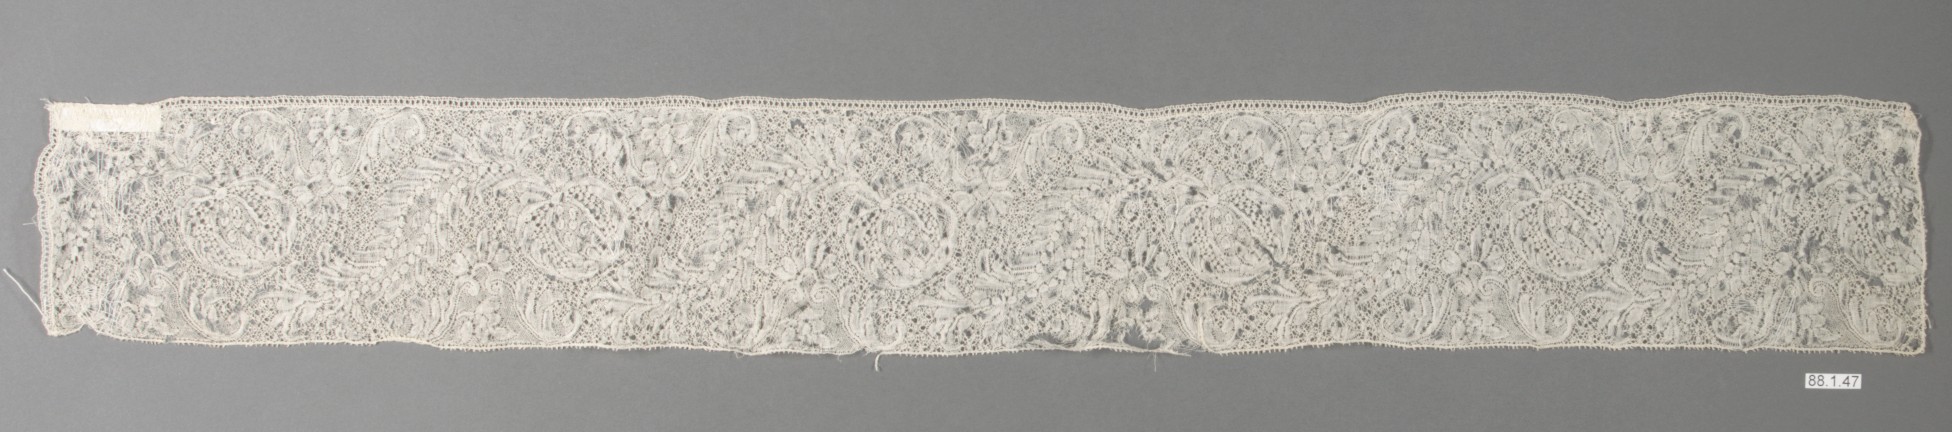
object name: insertion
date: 1675-1724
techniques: lace